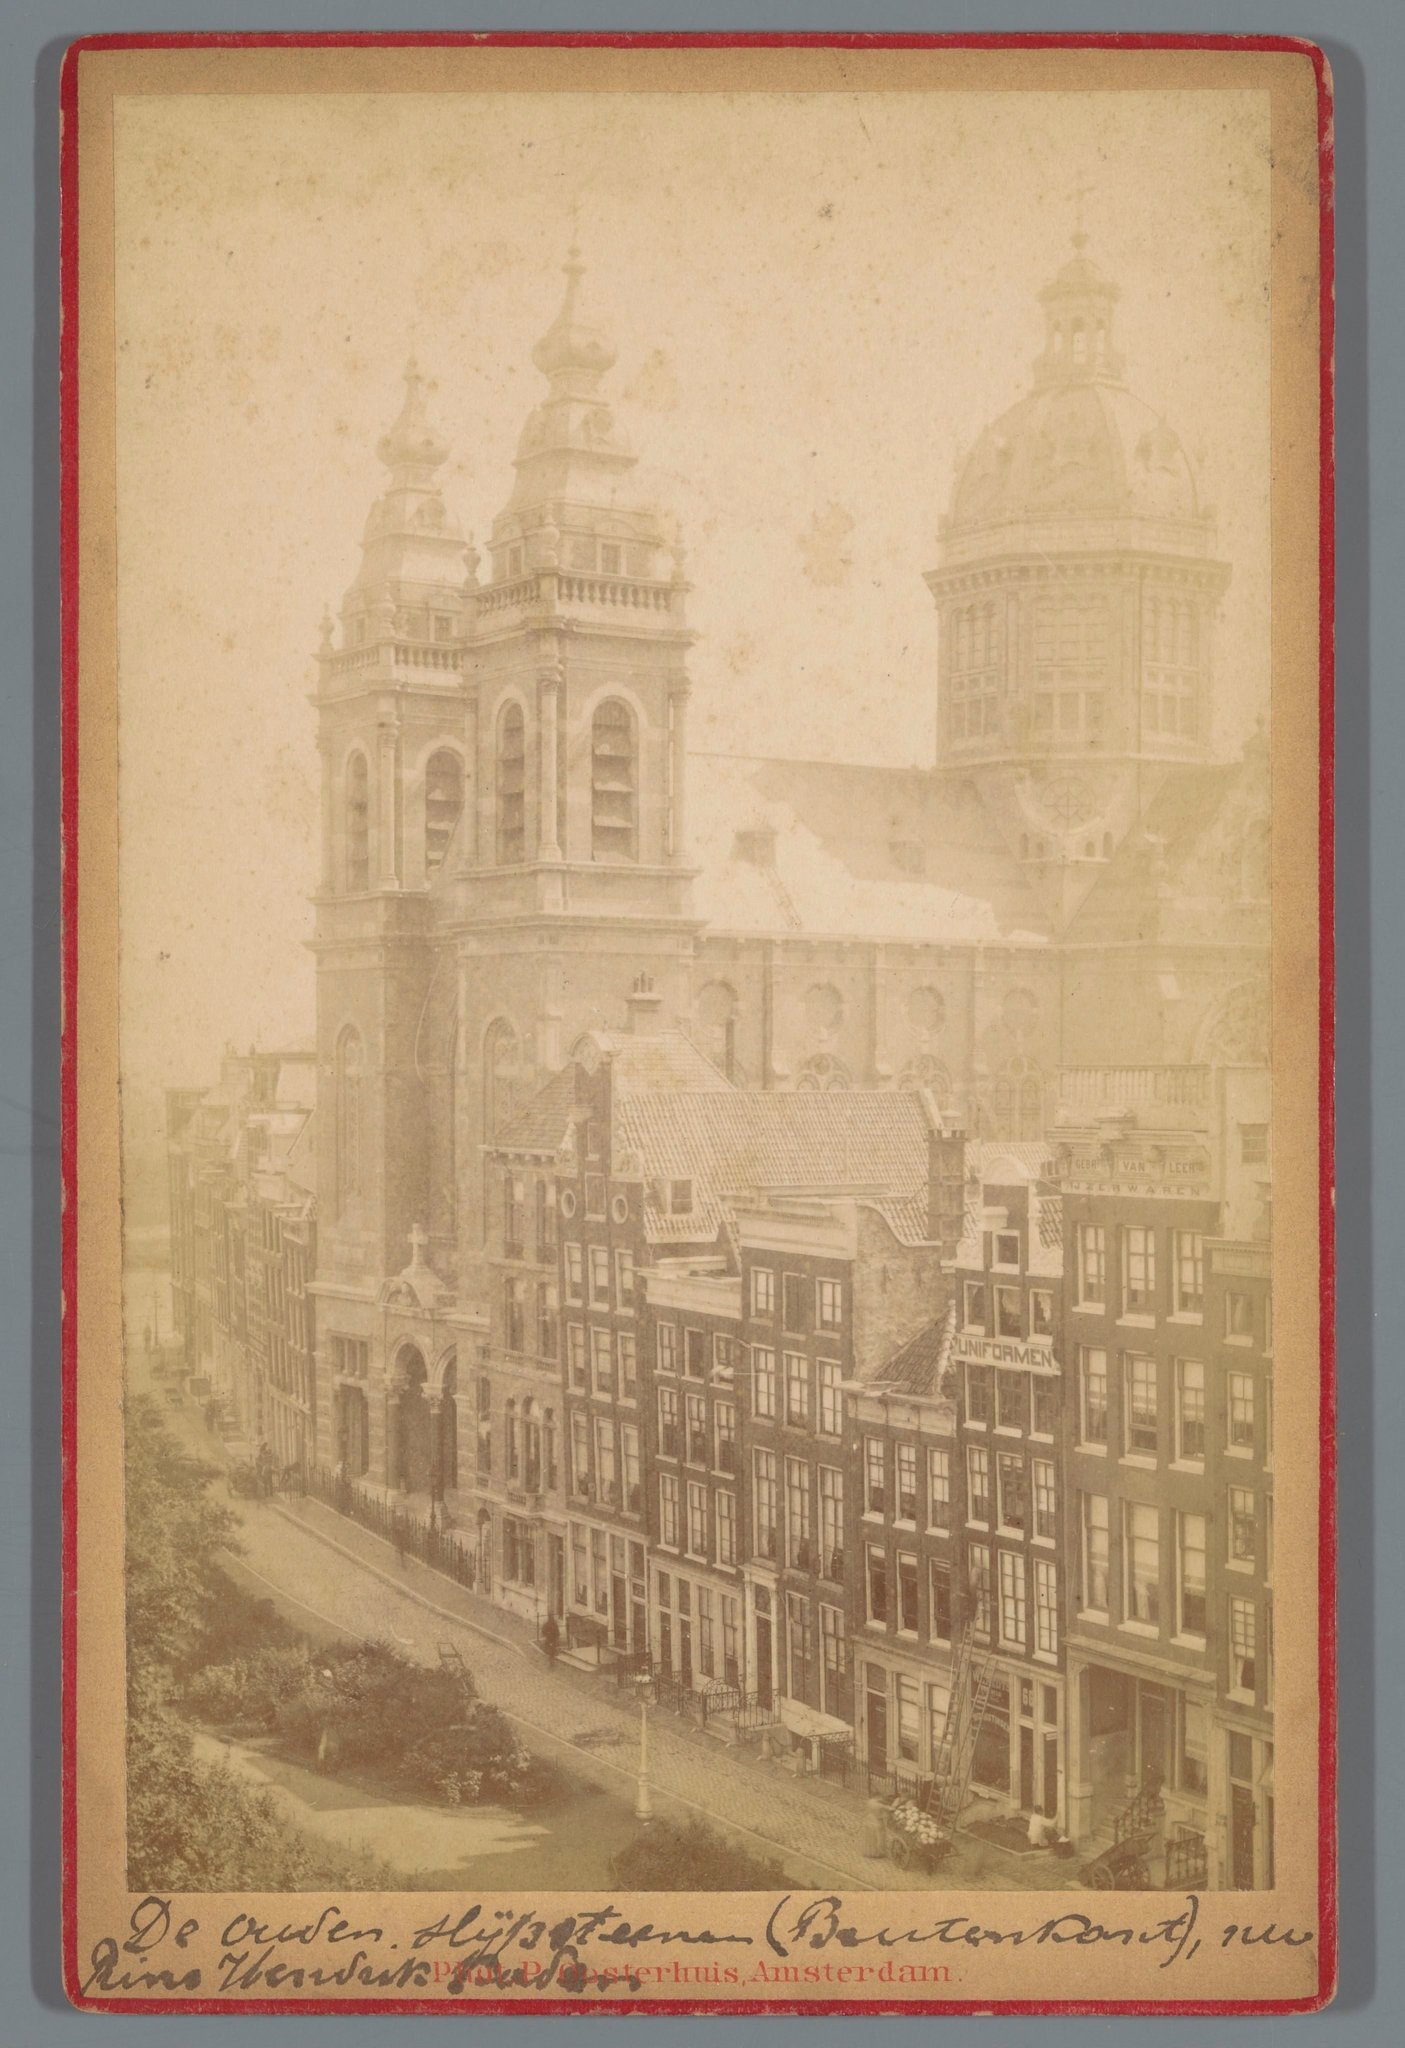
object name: cabinet photograph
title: Sint-Nicolaaskerk aan de Prins Hendrikkade, Amsterdam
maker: gustaaf oosterhuis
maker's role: fotograaf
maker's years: 1858-1938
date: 1887-1900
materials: cardboard, paper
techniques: albumen print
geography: amsterdam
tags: church (exterior), street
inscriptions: inscription: ‘Phot. P. Oosterhuis, Amsterdam.’